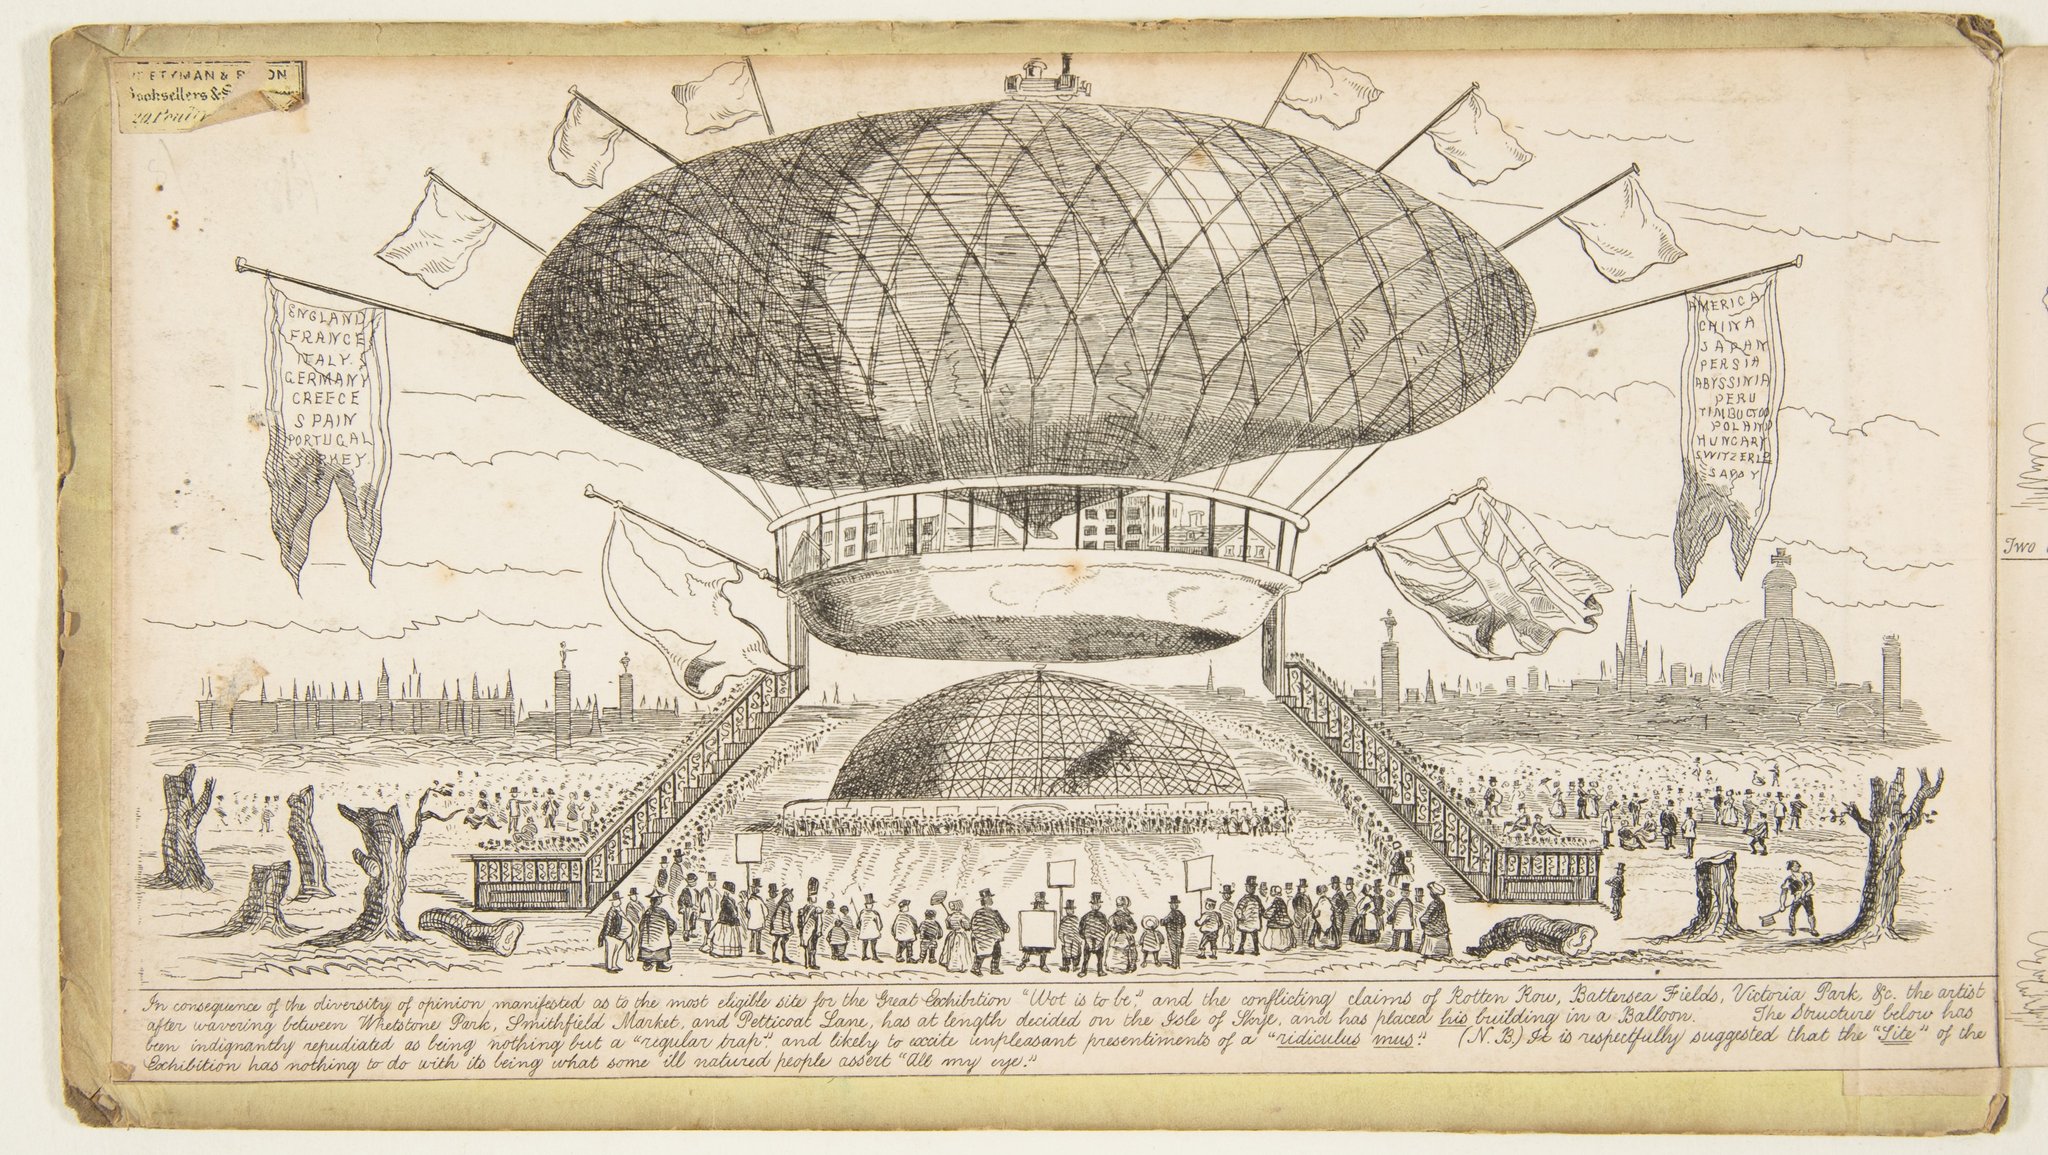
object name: print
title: The Great Exhibition "Wot is to Be", Probable Results of The Industry of All Nations in The Year '51, Showing What is to be Exhibited, Who is To Exhibit, in Short How Its All Going to Be Done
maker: george augustus sala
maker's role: author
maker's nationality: british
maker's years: 1828-1895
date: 1850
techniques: engraving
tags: crowd,working,flags